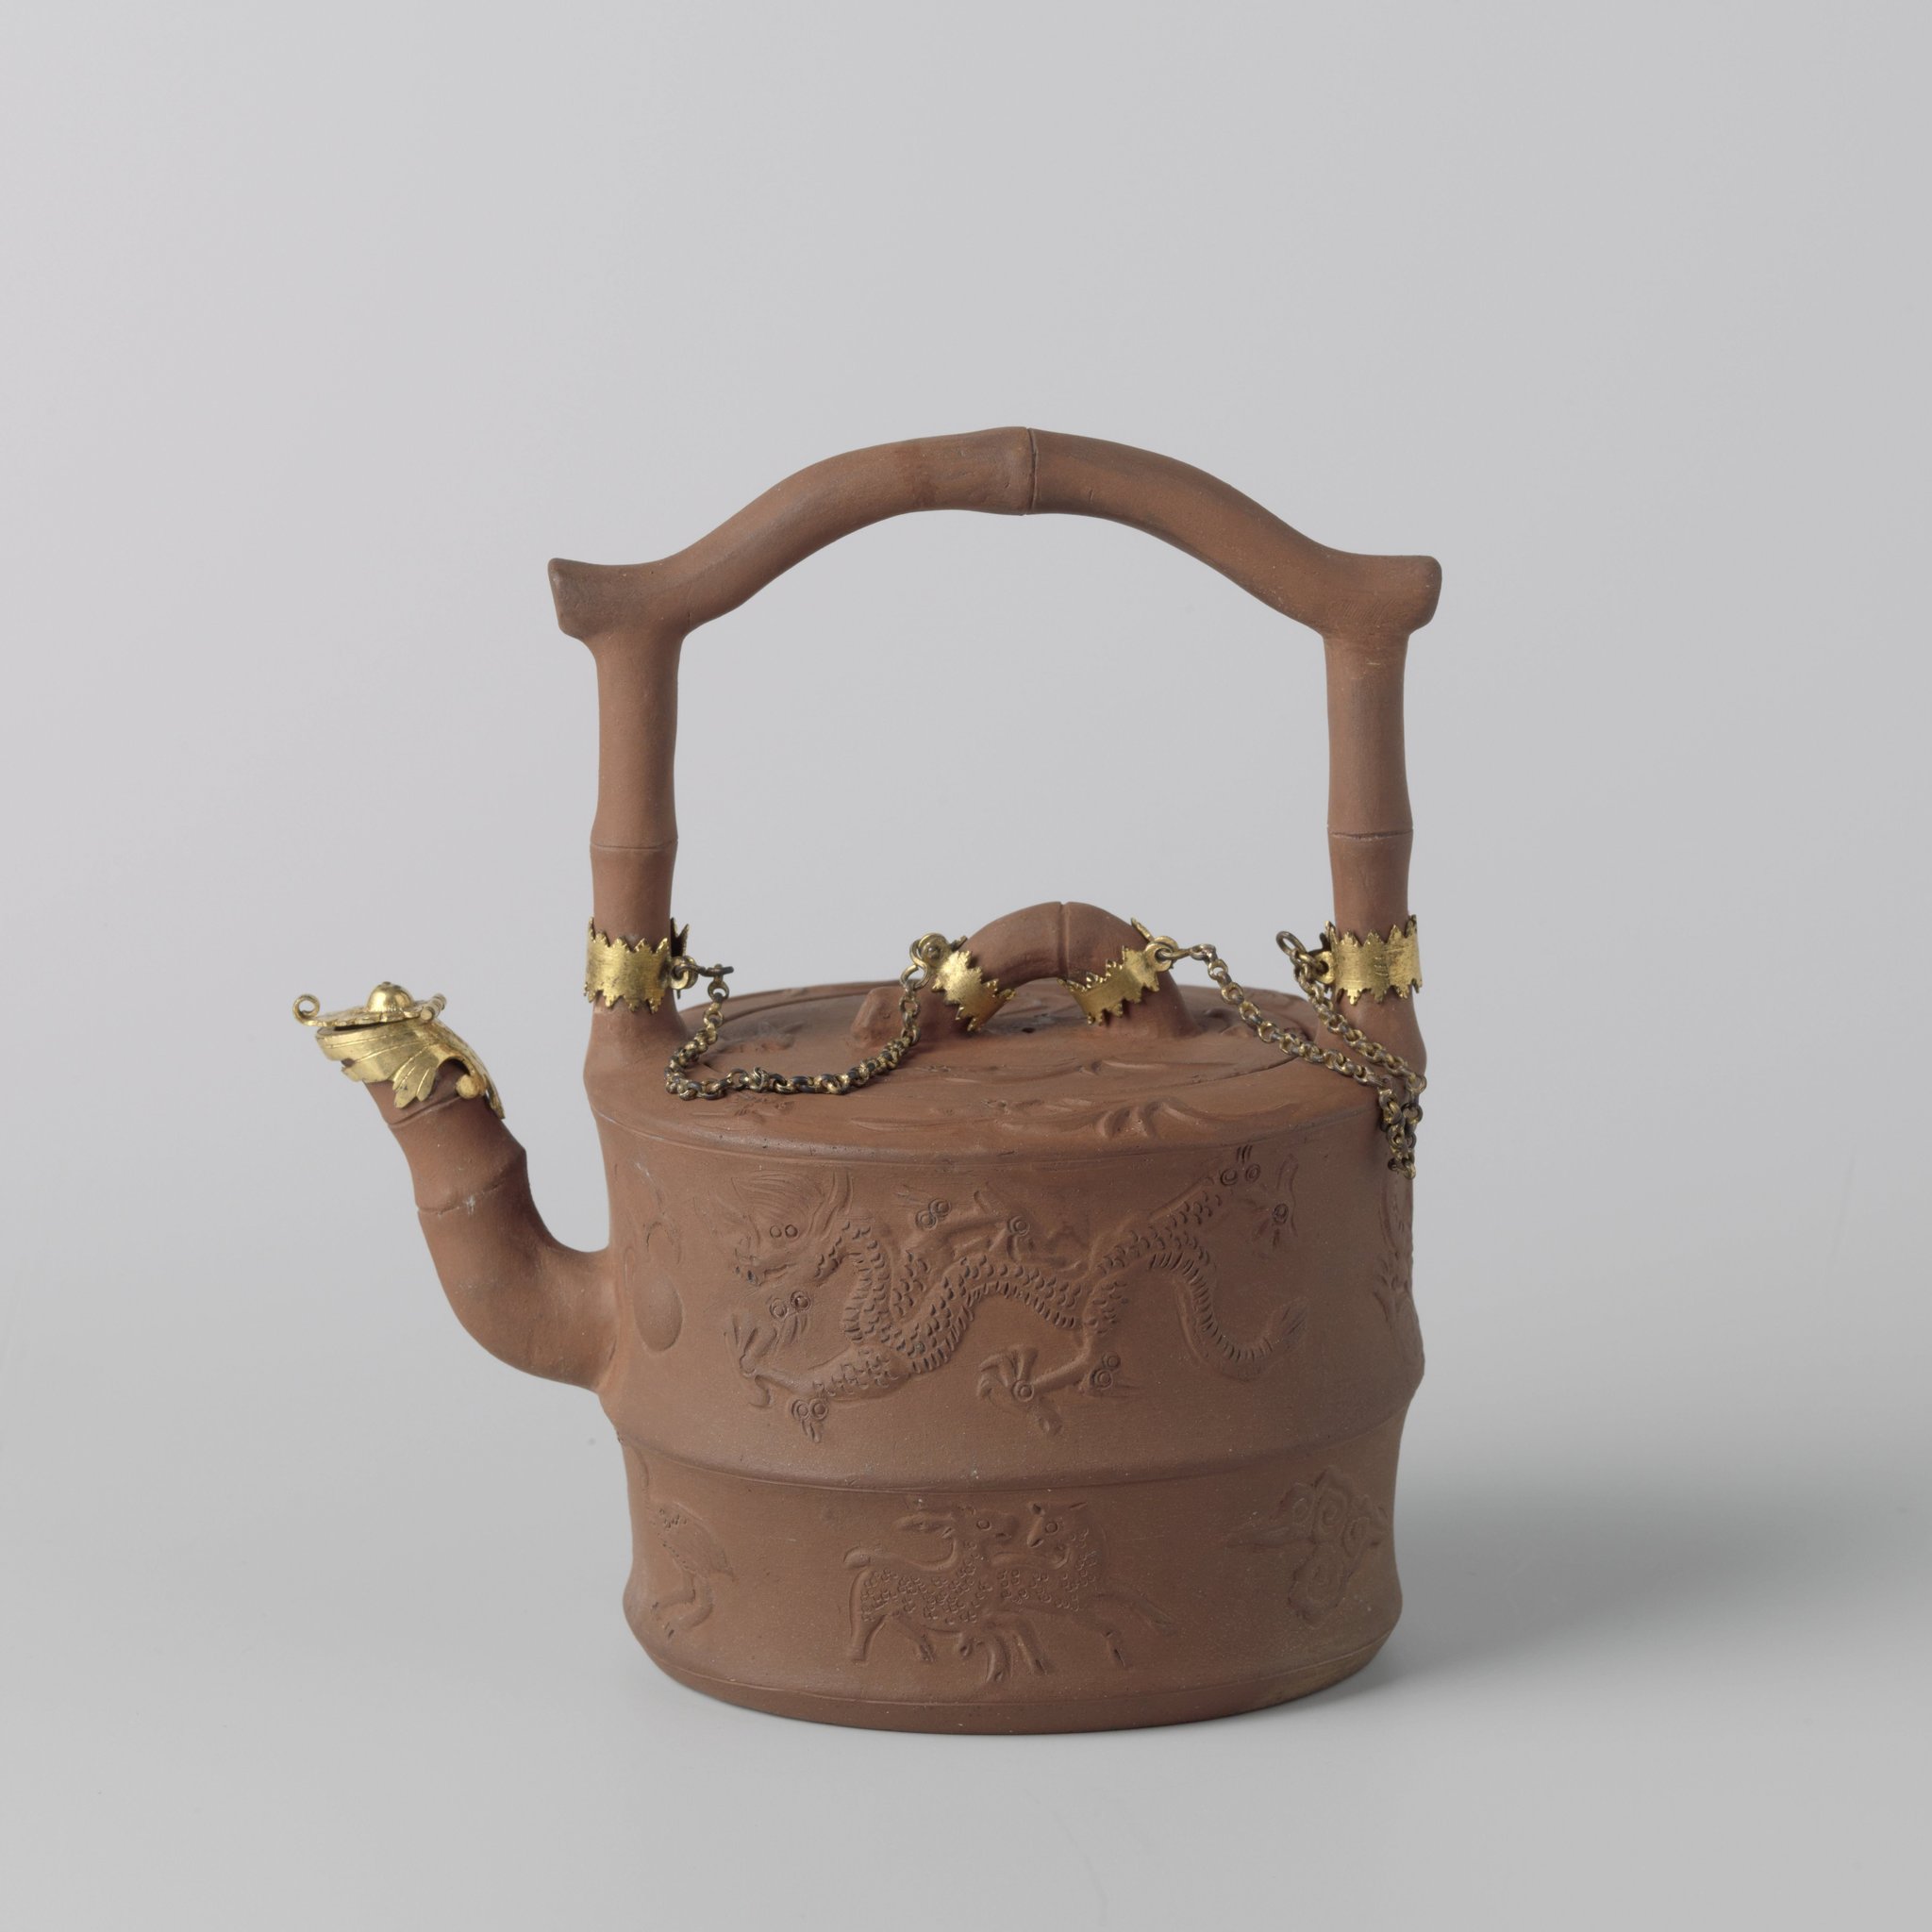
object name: teapot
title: Teapot with pearlchasing dragons, cranes and deer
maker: Anonymous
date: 1600-1699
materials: bronze, stoneware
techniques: firing, forming, gilding, relief, turning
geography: china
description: The body, handle, and spout of this teapot resemble bamboo stalks. The decoration comprises two layers: the upper layer portrays dragons in pursuit of a pearl, while the lower one features auspicious motifs, including deer, cranes, and clouds. A seam on the pot’s body reveals its construction, consisting of two halves that were cast in a mould and joined together.